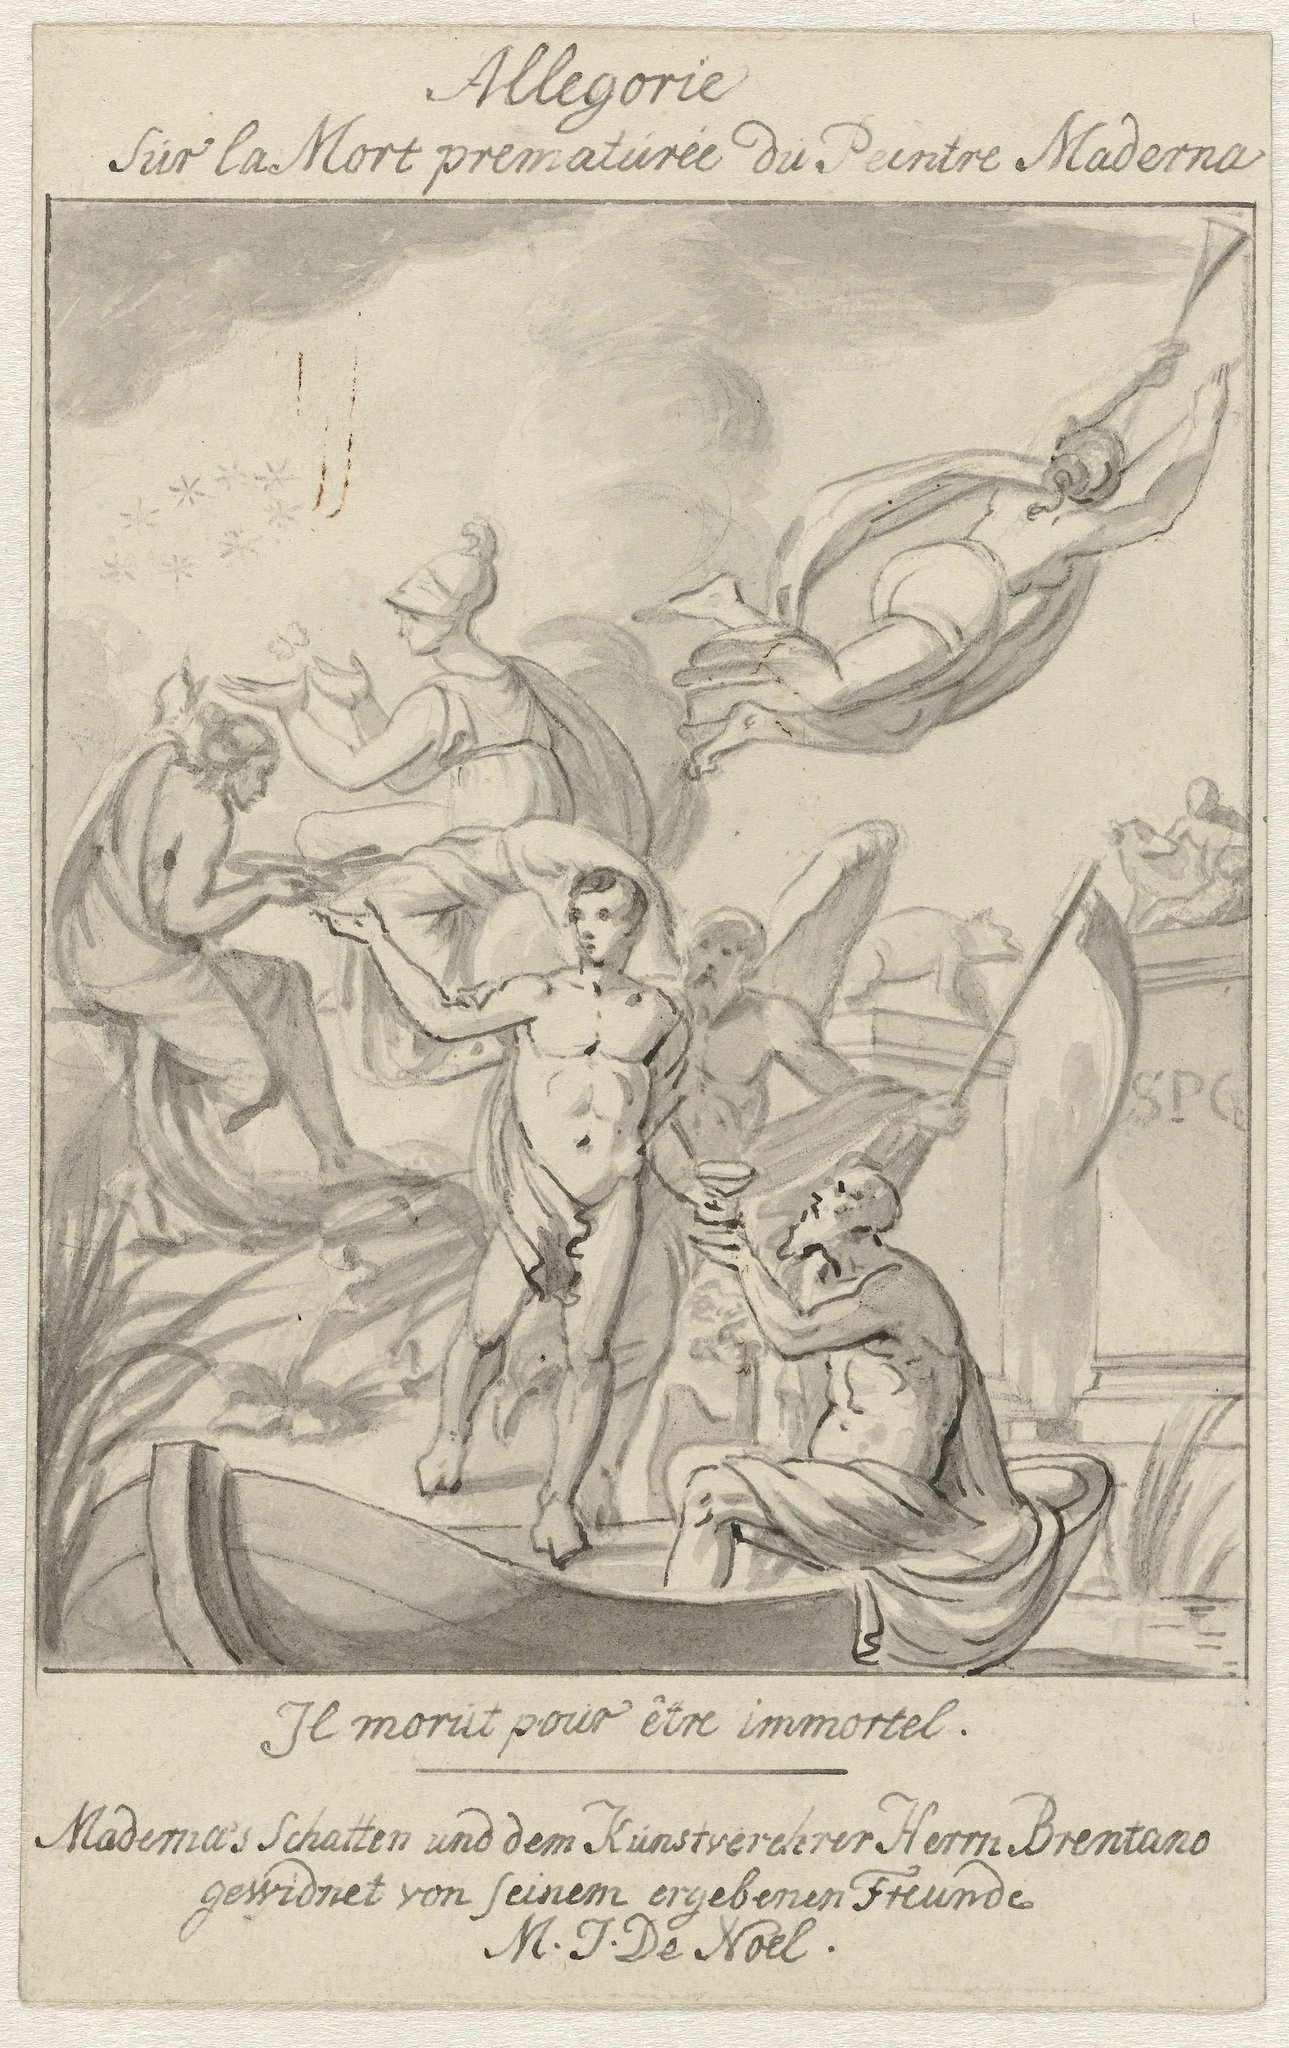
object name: drawing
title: Allegorie op het overlijden van de kunstenaar Giambattista Maderna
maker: matthias joseph de noël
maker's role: draughtsman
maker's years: 1782-1849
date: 1792-1849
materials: ink, paper, pencil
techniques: brush, pen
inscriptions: inscription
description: Allegorie op het overlijden van de kunstenaar Giambattista Maderna (Verona 1758-1803 Stockholm).